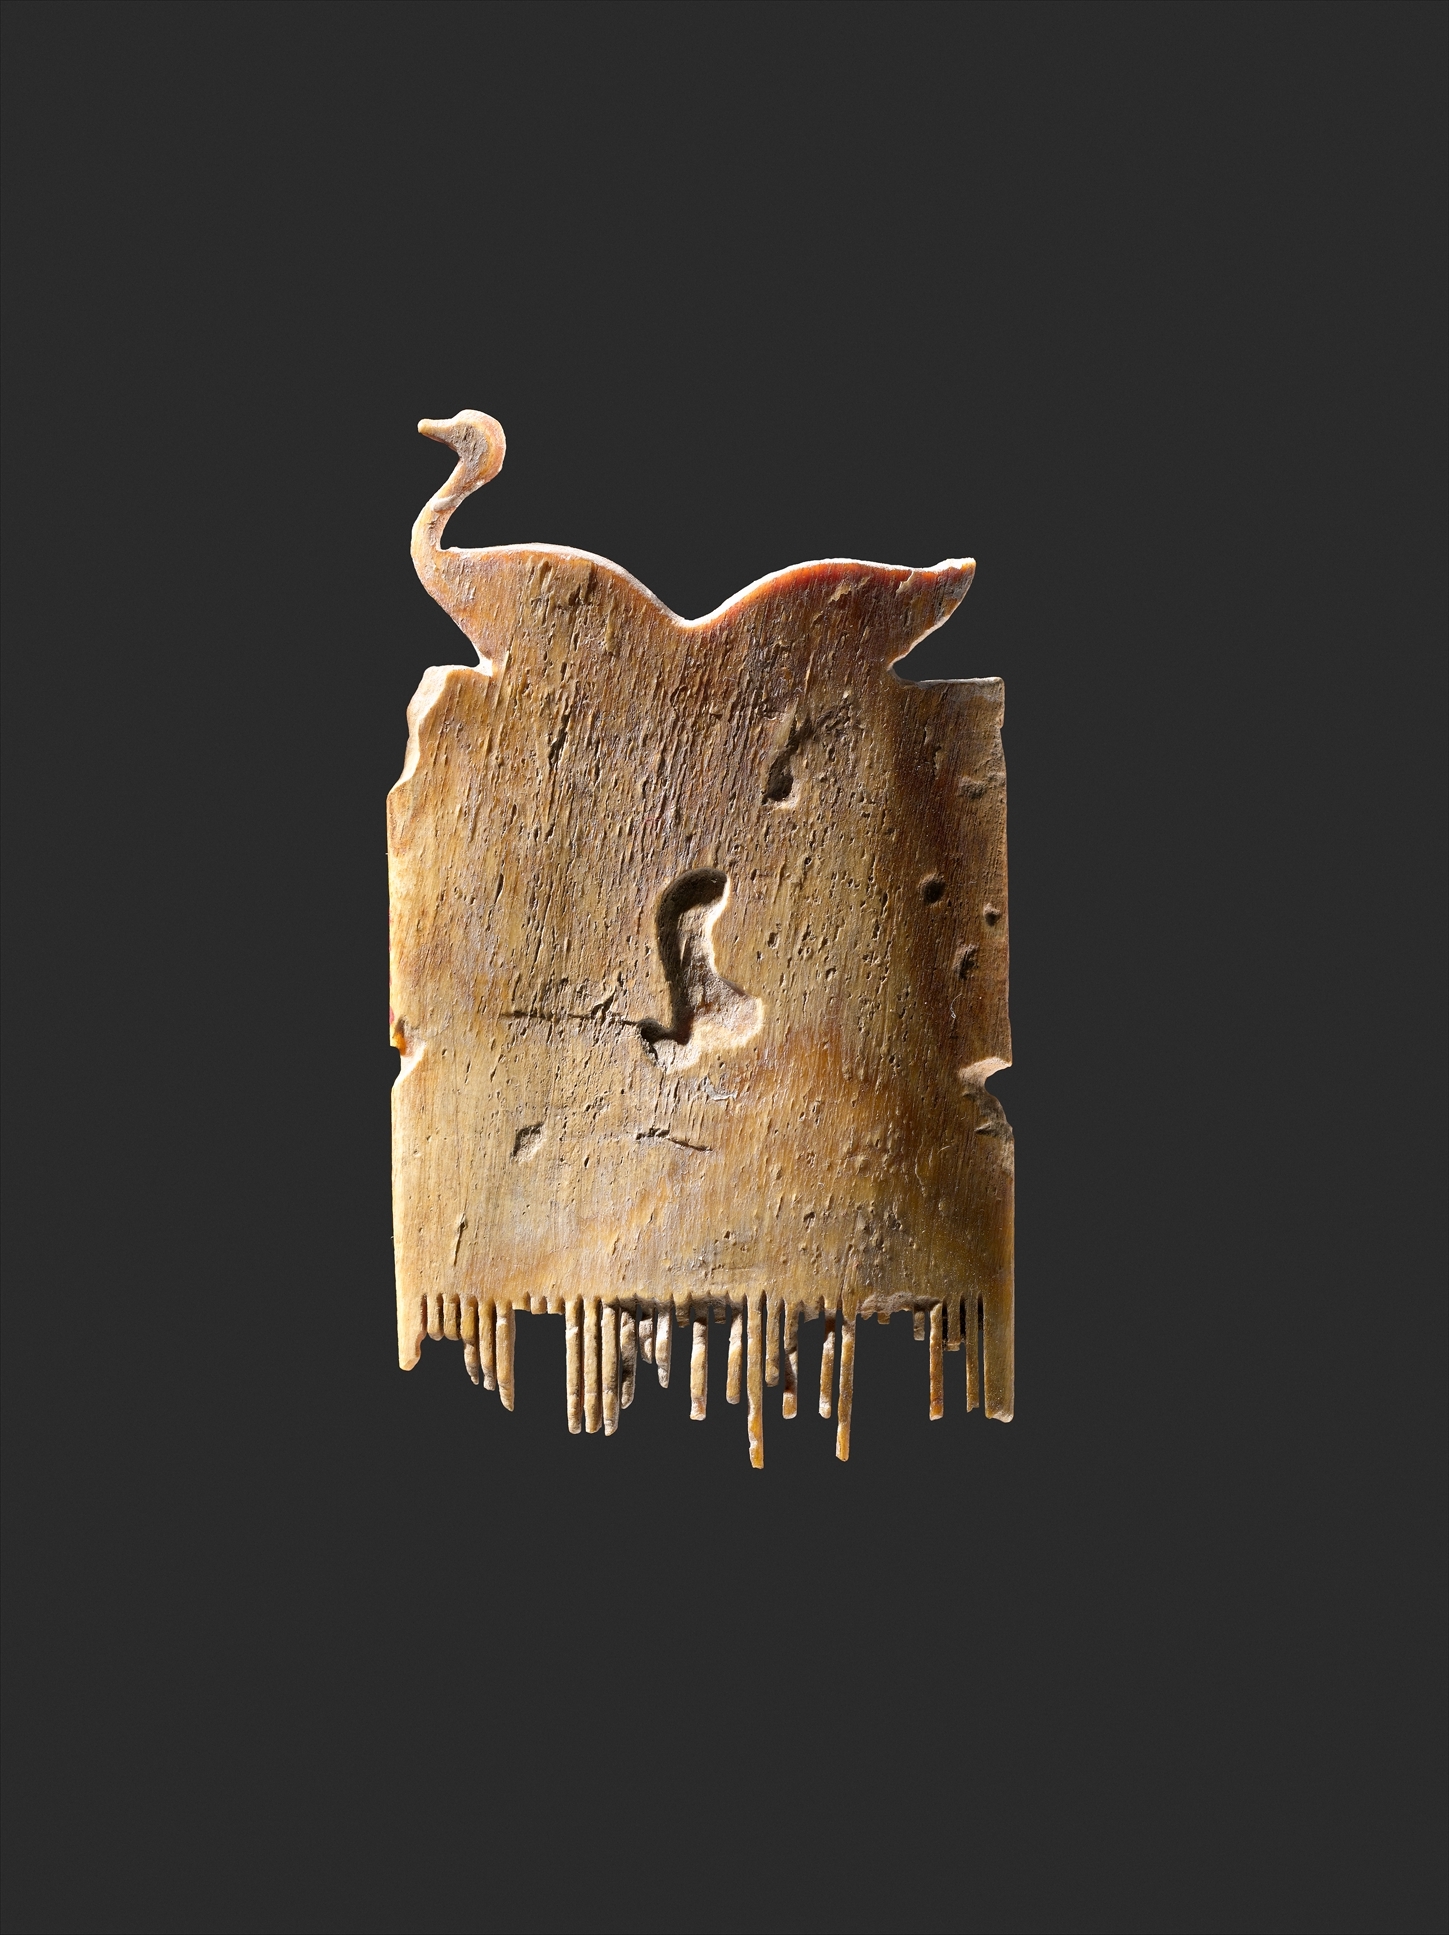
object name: comb, pair of duck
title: Comb with a pair of ducks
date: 3900-3500 BCE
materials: horn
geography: egypt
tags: ducks